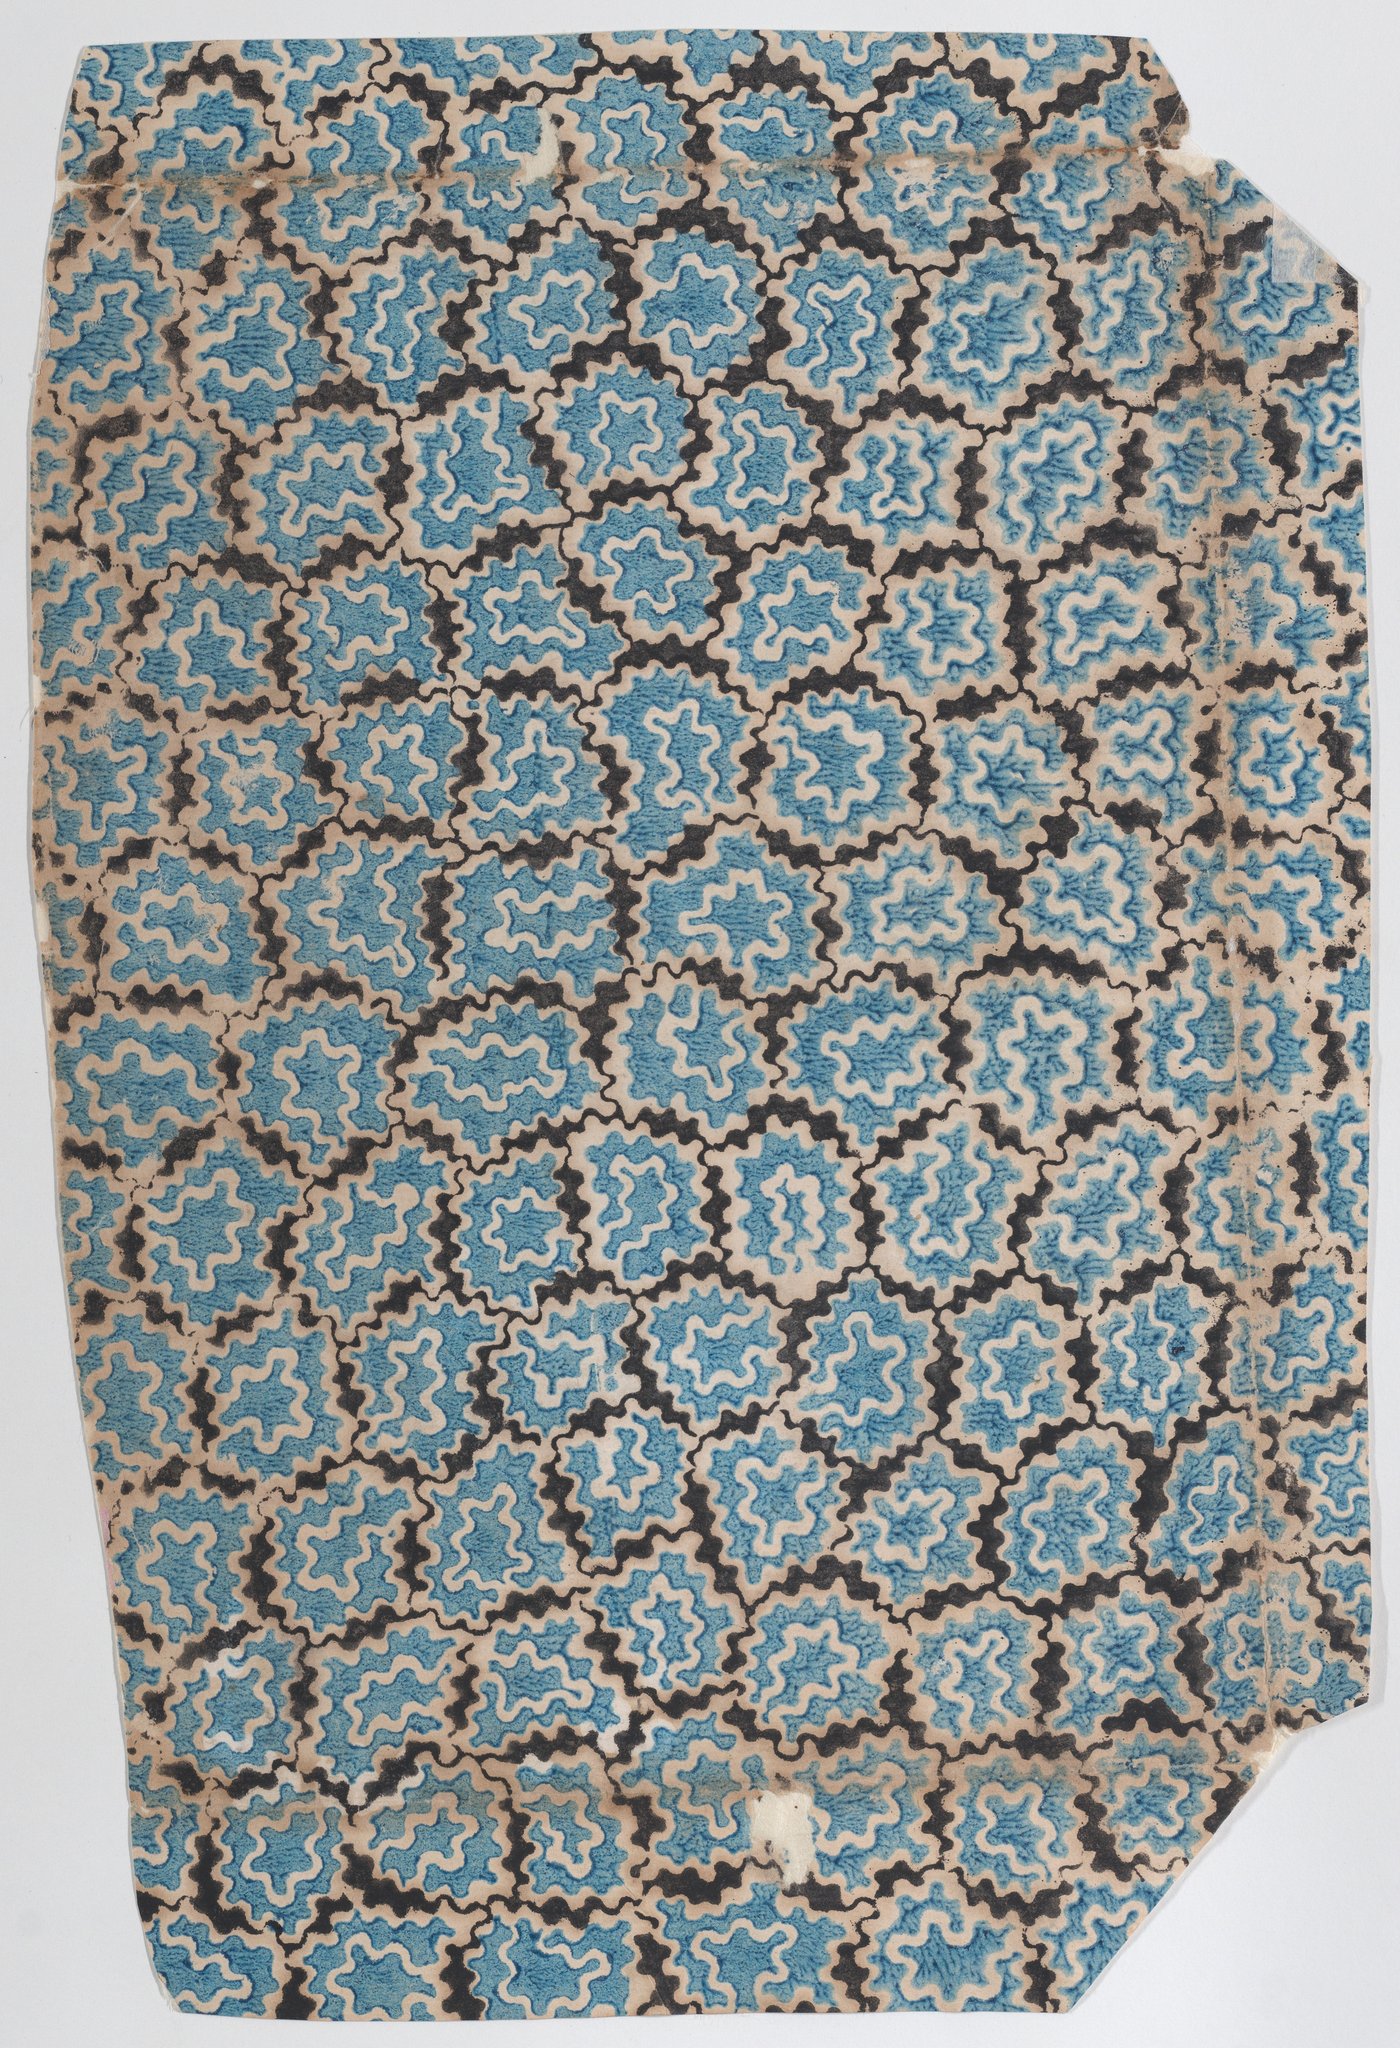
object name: print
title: Sheet with an overall pattern of organic shapes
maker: Anonymous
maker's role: artist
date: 1801-1900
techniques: relief print